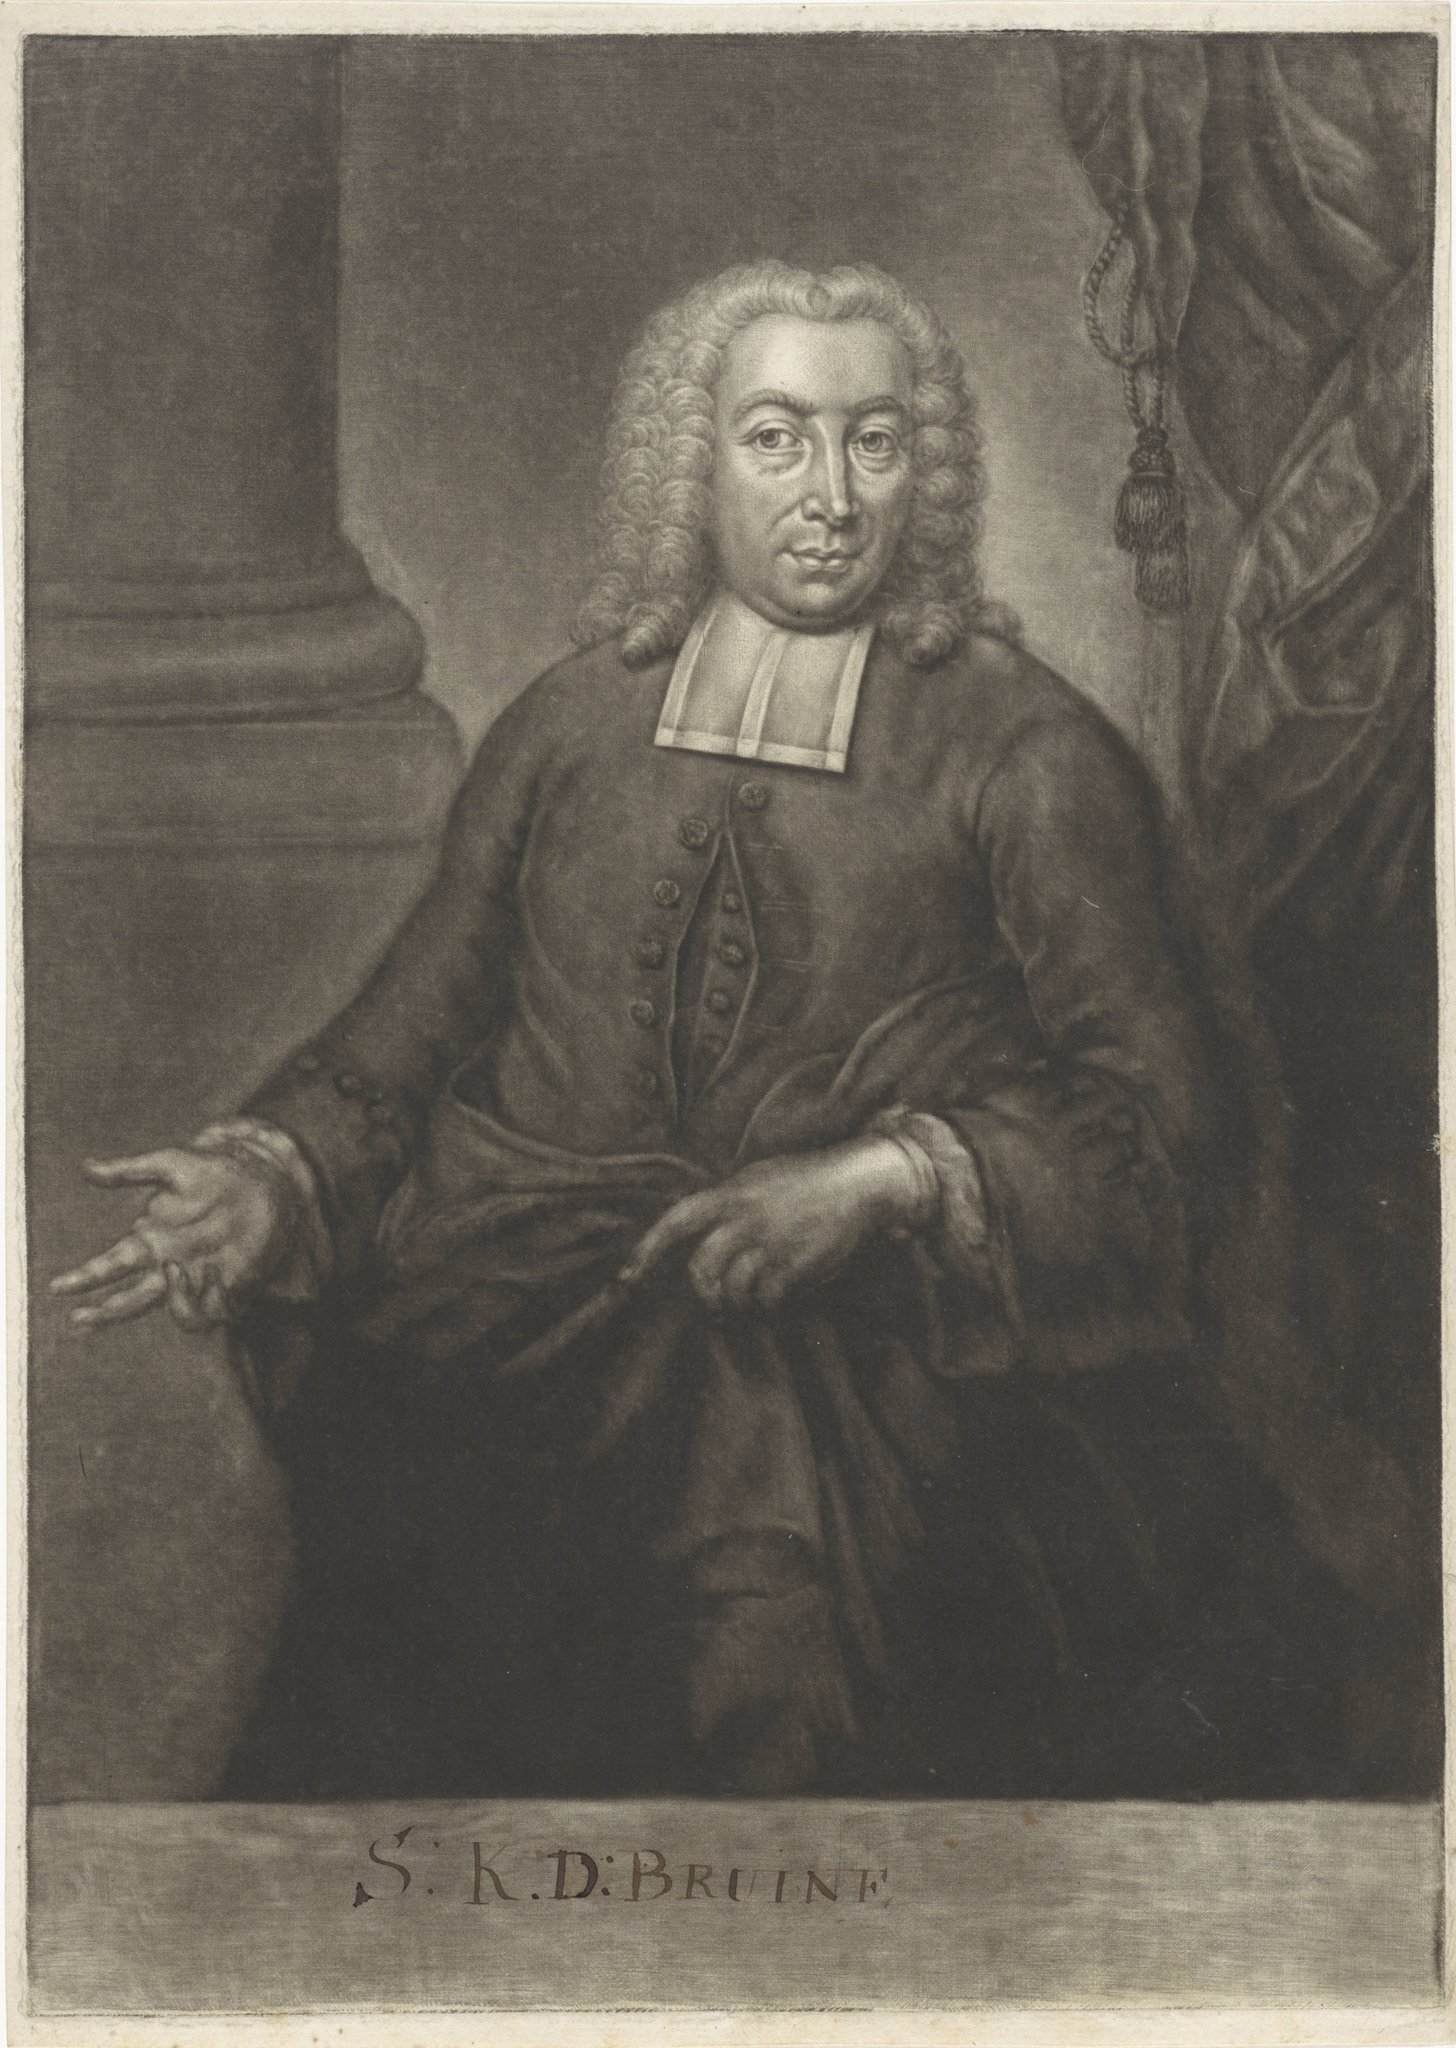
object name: print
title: Portret van Samuel Koenraad de Bruine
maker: johannes van vilsteren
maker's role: print maker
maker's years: -1763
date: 1723-1763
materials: paper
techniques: mezzotint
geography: northern netherlands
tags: amsterdam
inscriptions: collector's mark: Lugt 2228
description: De predikant Samuel Koenraad de Bruine staat voor een gordijn en een zuil.